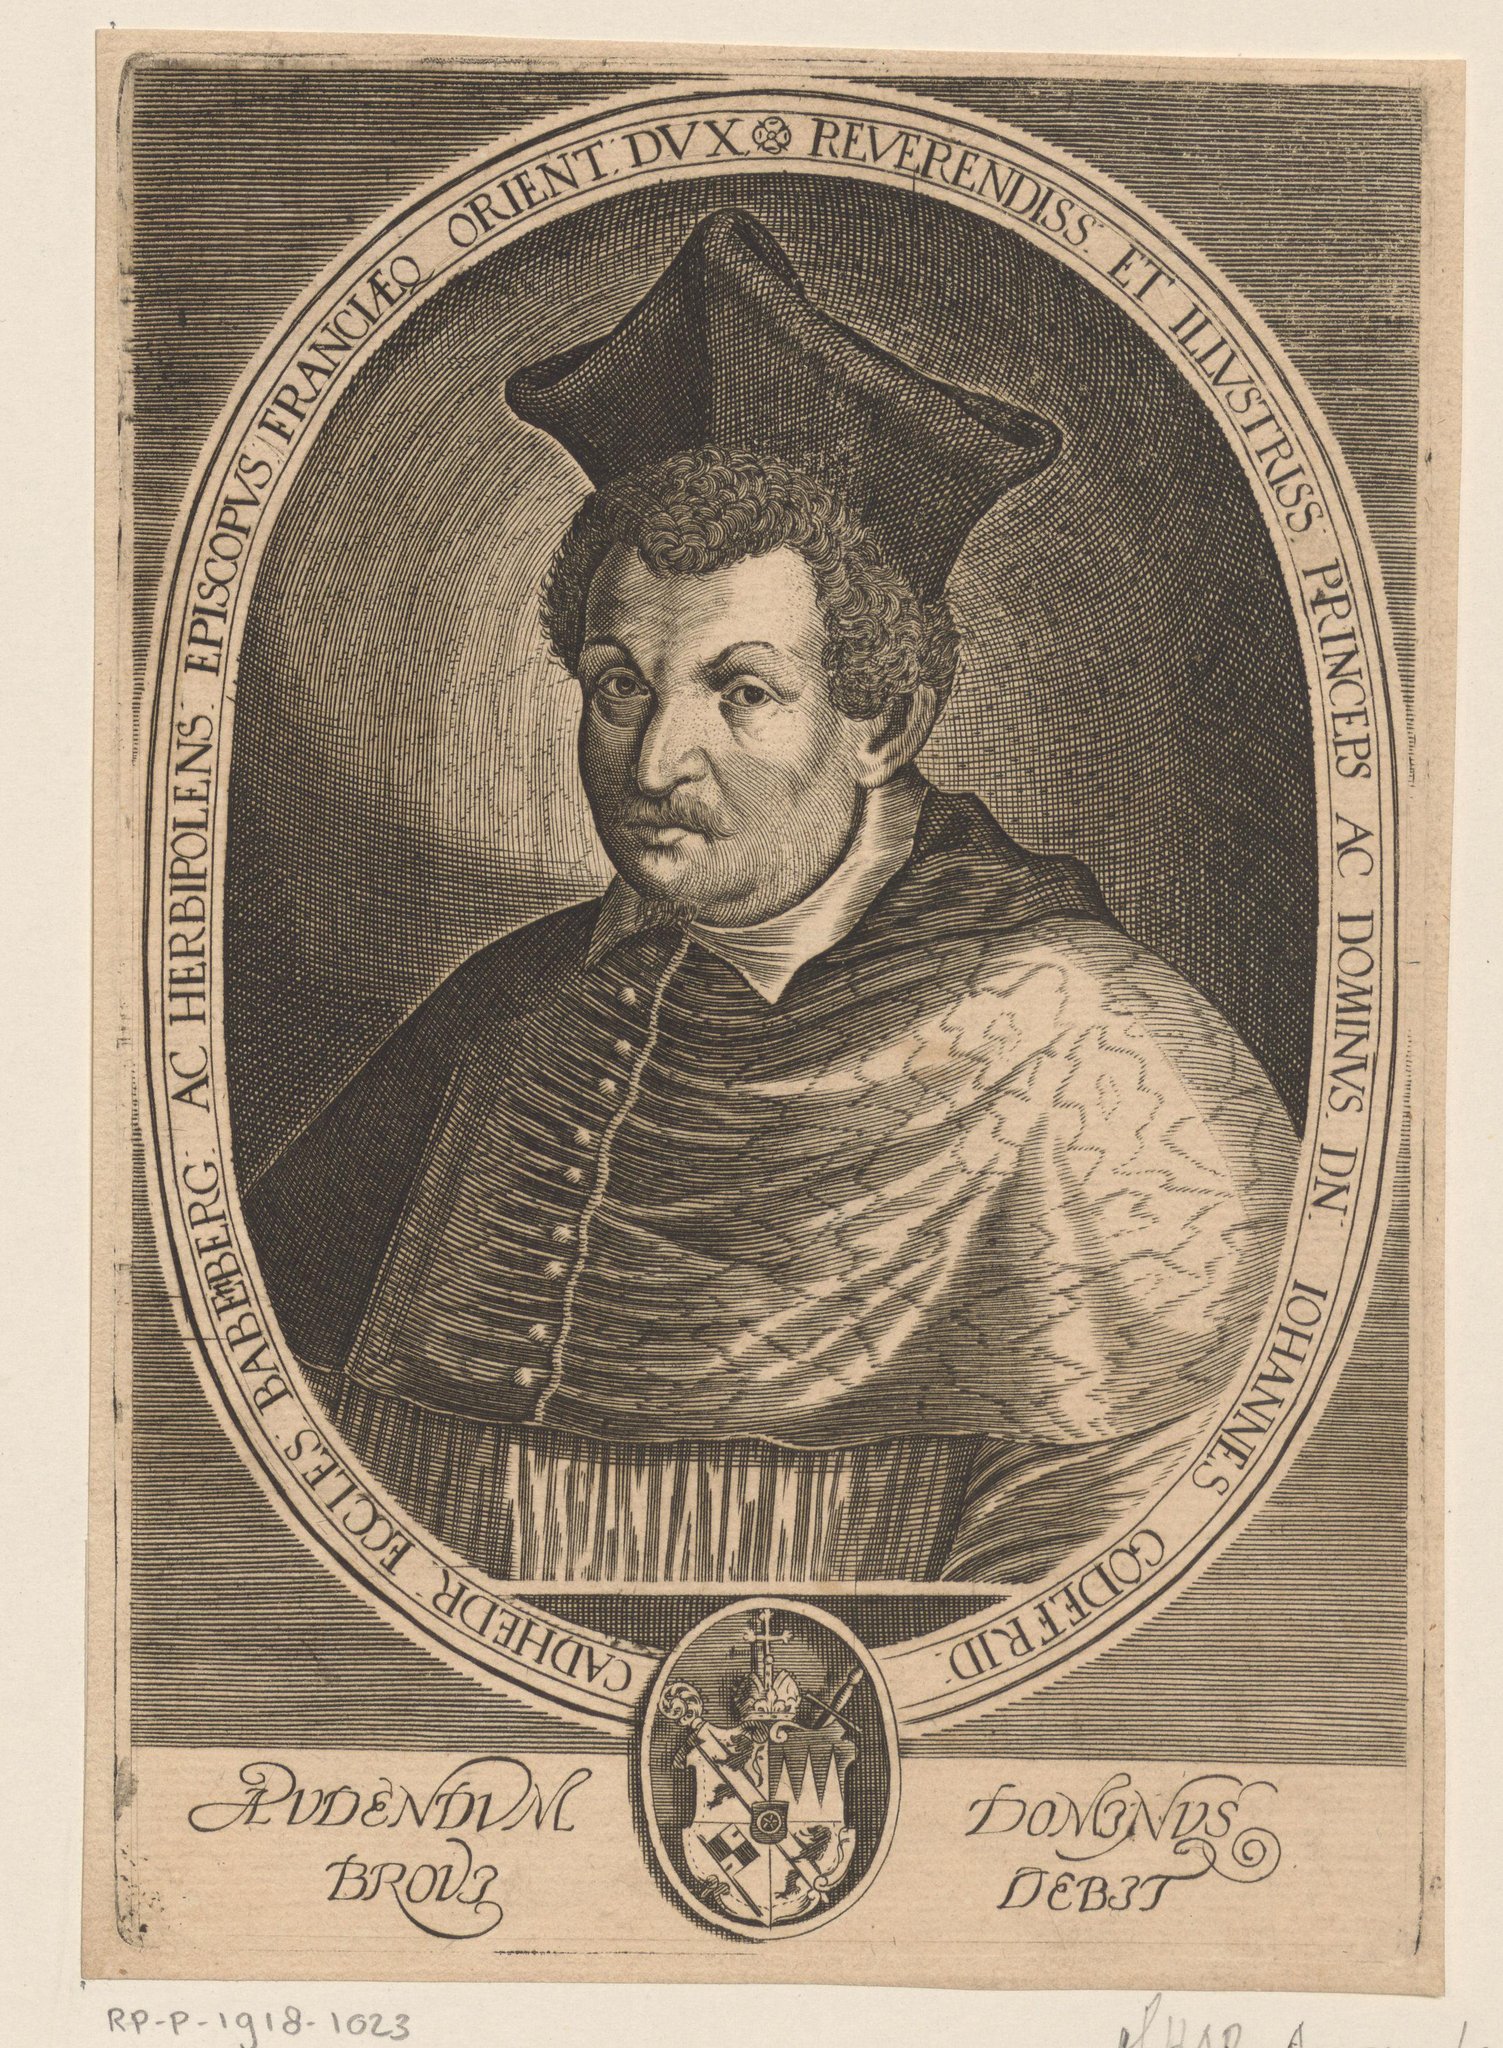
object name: print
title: Portret van Johann Gottfried van Aschhausen, prins-bisschop van Bamberg en Würzburg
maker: Anonymous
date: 1600-1649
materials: paper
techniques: engraving, etching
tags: historical persons, armorial bearing, heraldry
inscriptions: collector's mark: Lugt 2233